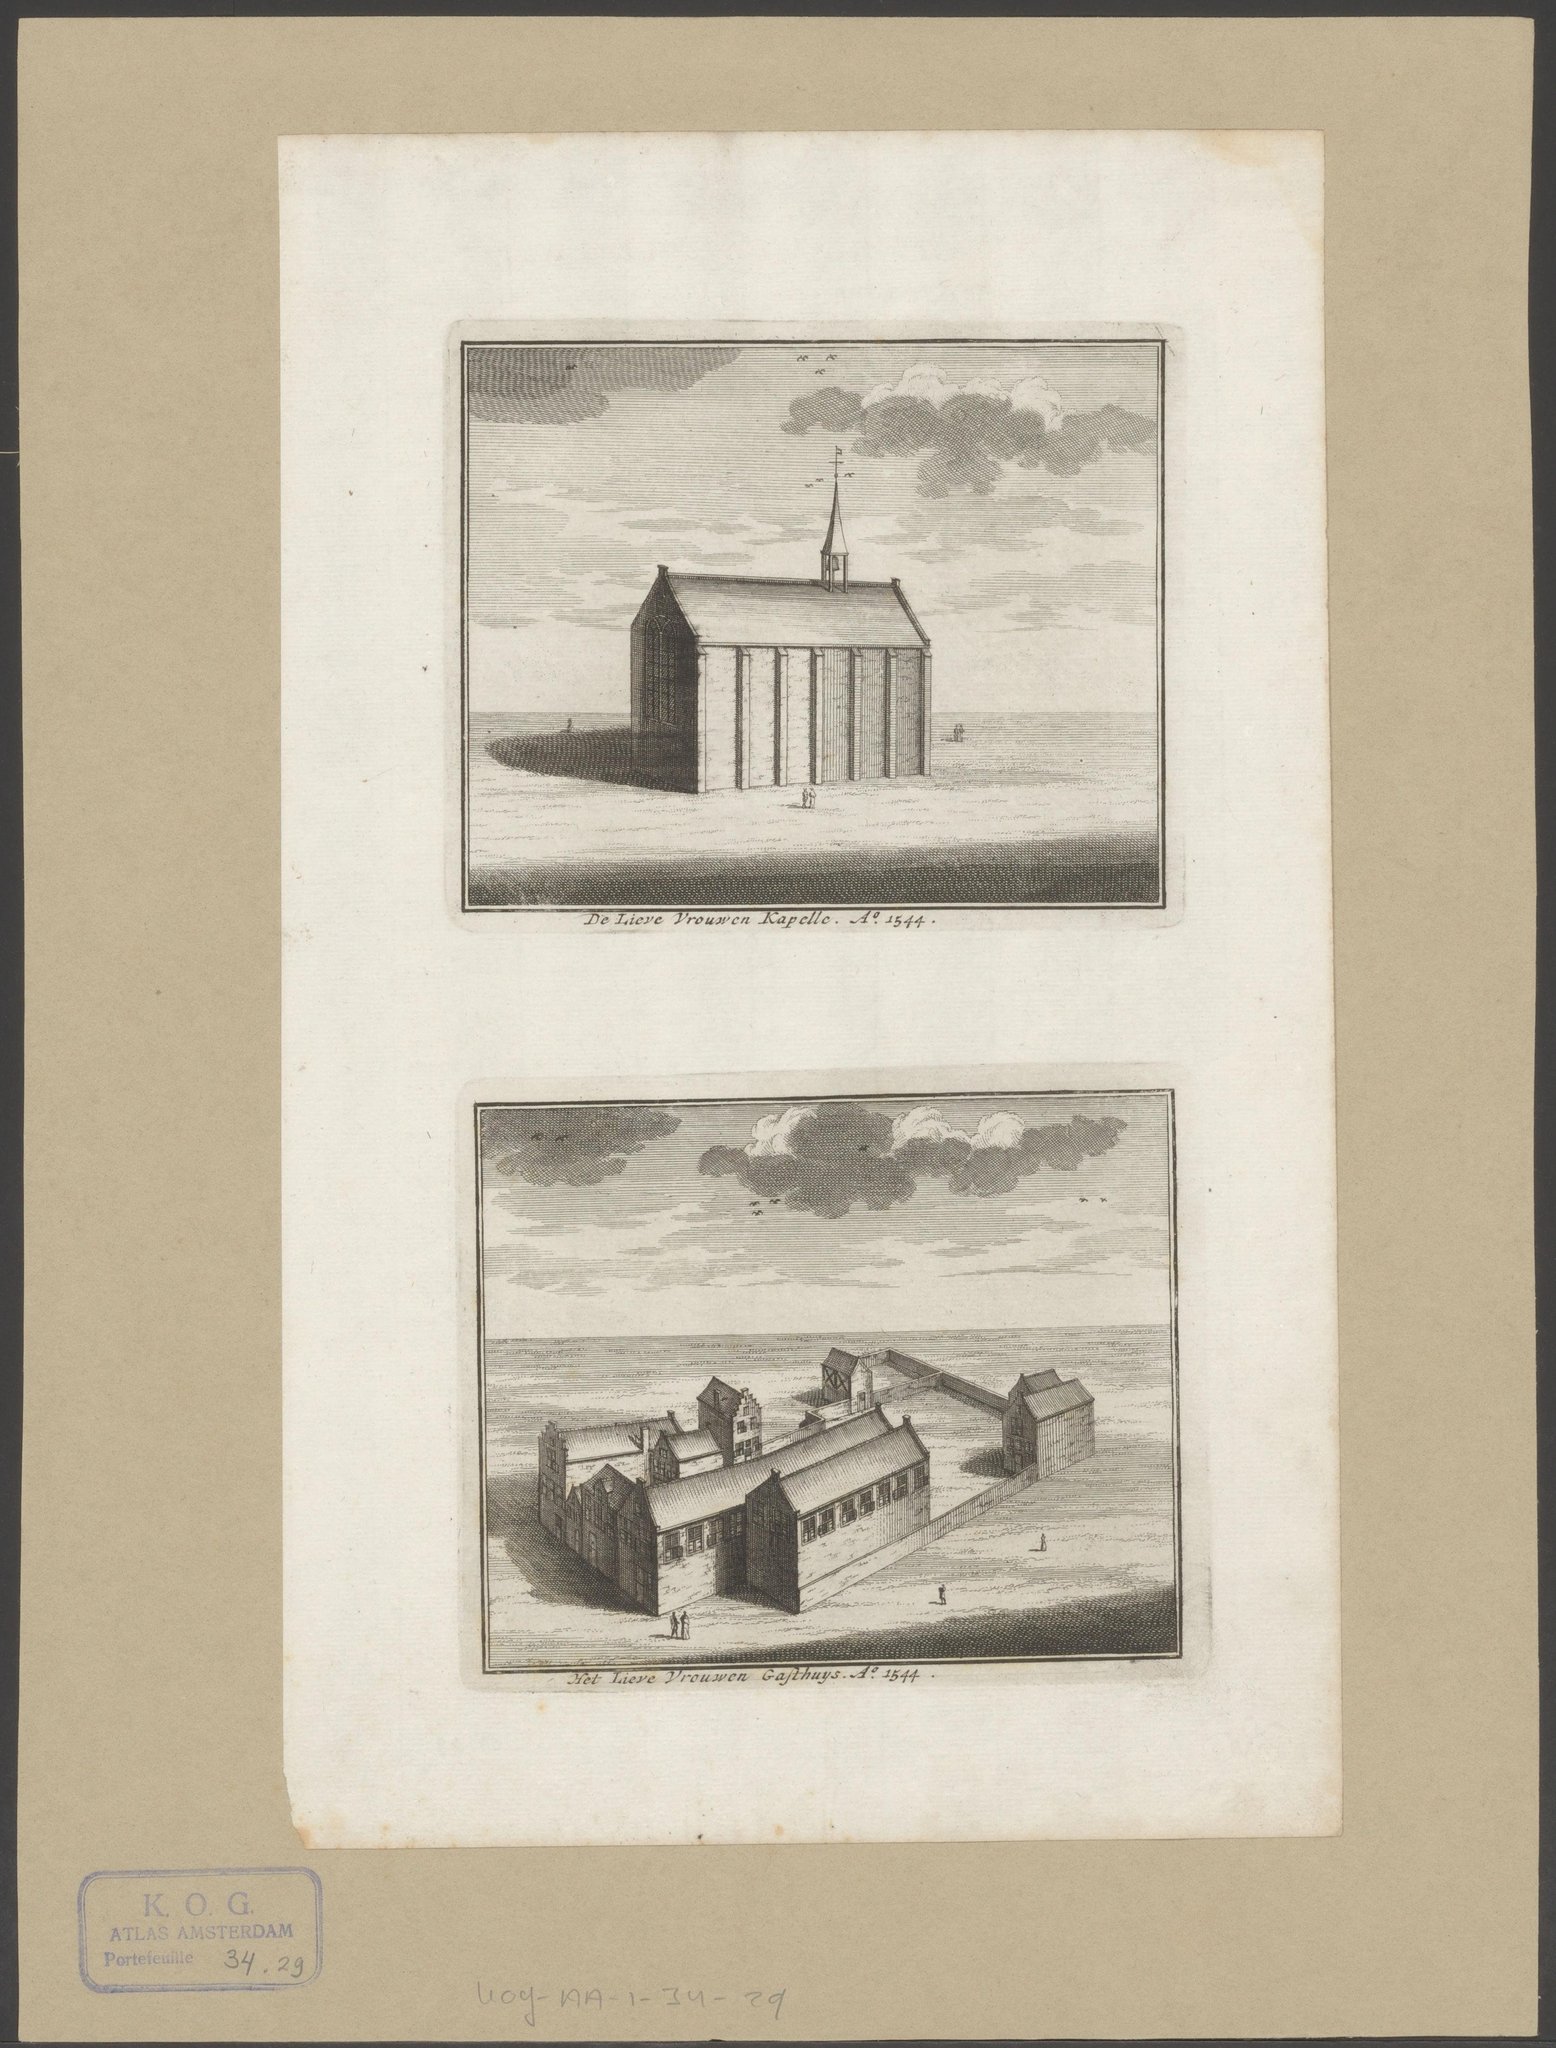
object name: print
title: Het Lieve Vrouwen Gasthuys. Ao. 1544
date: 1729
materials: paper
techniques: engraving, etching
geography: amsterdam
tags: hospital, church (exterior) - qq - small church, chapel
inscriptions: collector's mark: Lugt 1641b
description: Prent mogelijk uit: Long, Isaac le. Historische beschryvinge van de reformatie der stadt Amsterdam (…). Amsterdam: Johannes van Septeren (I), 1729. Dat de prent de situatie rond 1544 weergeeft, gaat terug op het feit dat voor het maken van deze en andere prenten van kloosters en kerken van voor de Alteratie (1578) is uitgegaan van de plattegrond van Cornelis Anthonisz. uit 1544, zie RP-P-OB-70.399 en RP-P-AO-20-15.